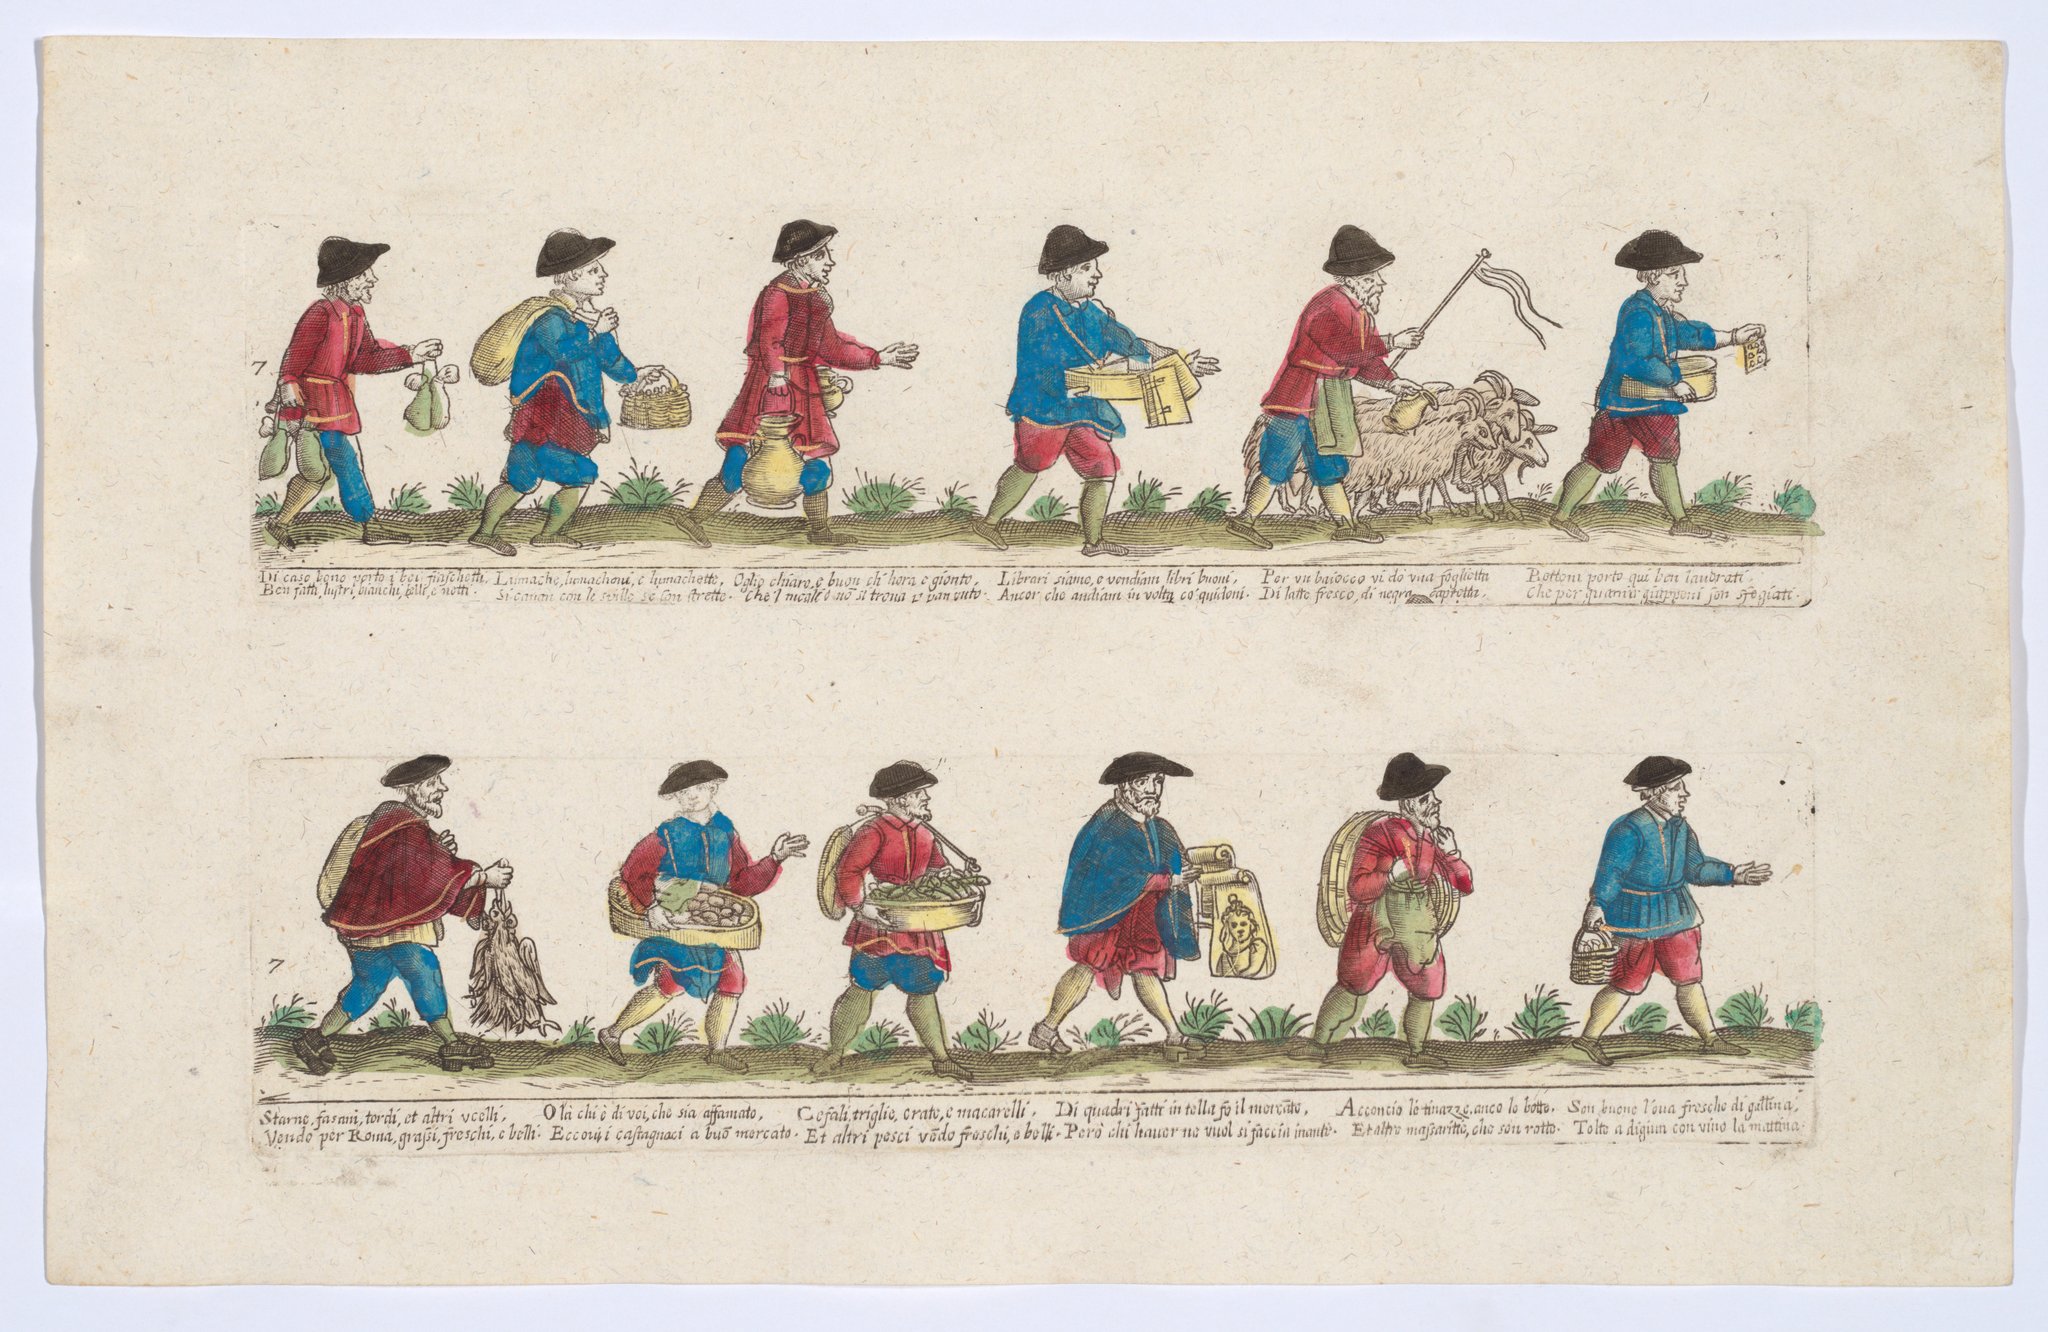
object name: print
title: Plate 7 depicting the trades of Rome, here including vendors of books, chestnuts, portraits etc, from the 'Descrición de las artes que se llaman para los calles de la ciudad de Roma'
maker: remondini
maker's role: publisher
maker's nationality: italian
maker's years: 1650-1860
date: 1770-1800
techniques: engraving, hand coloring